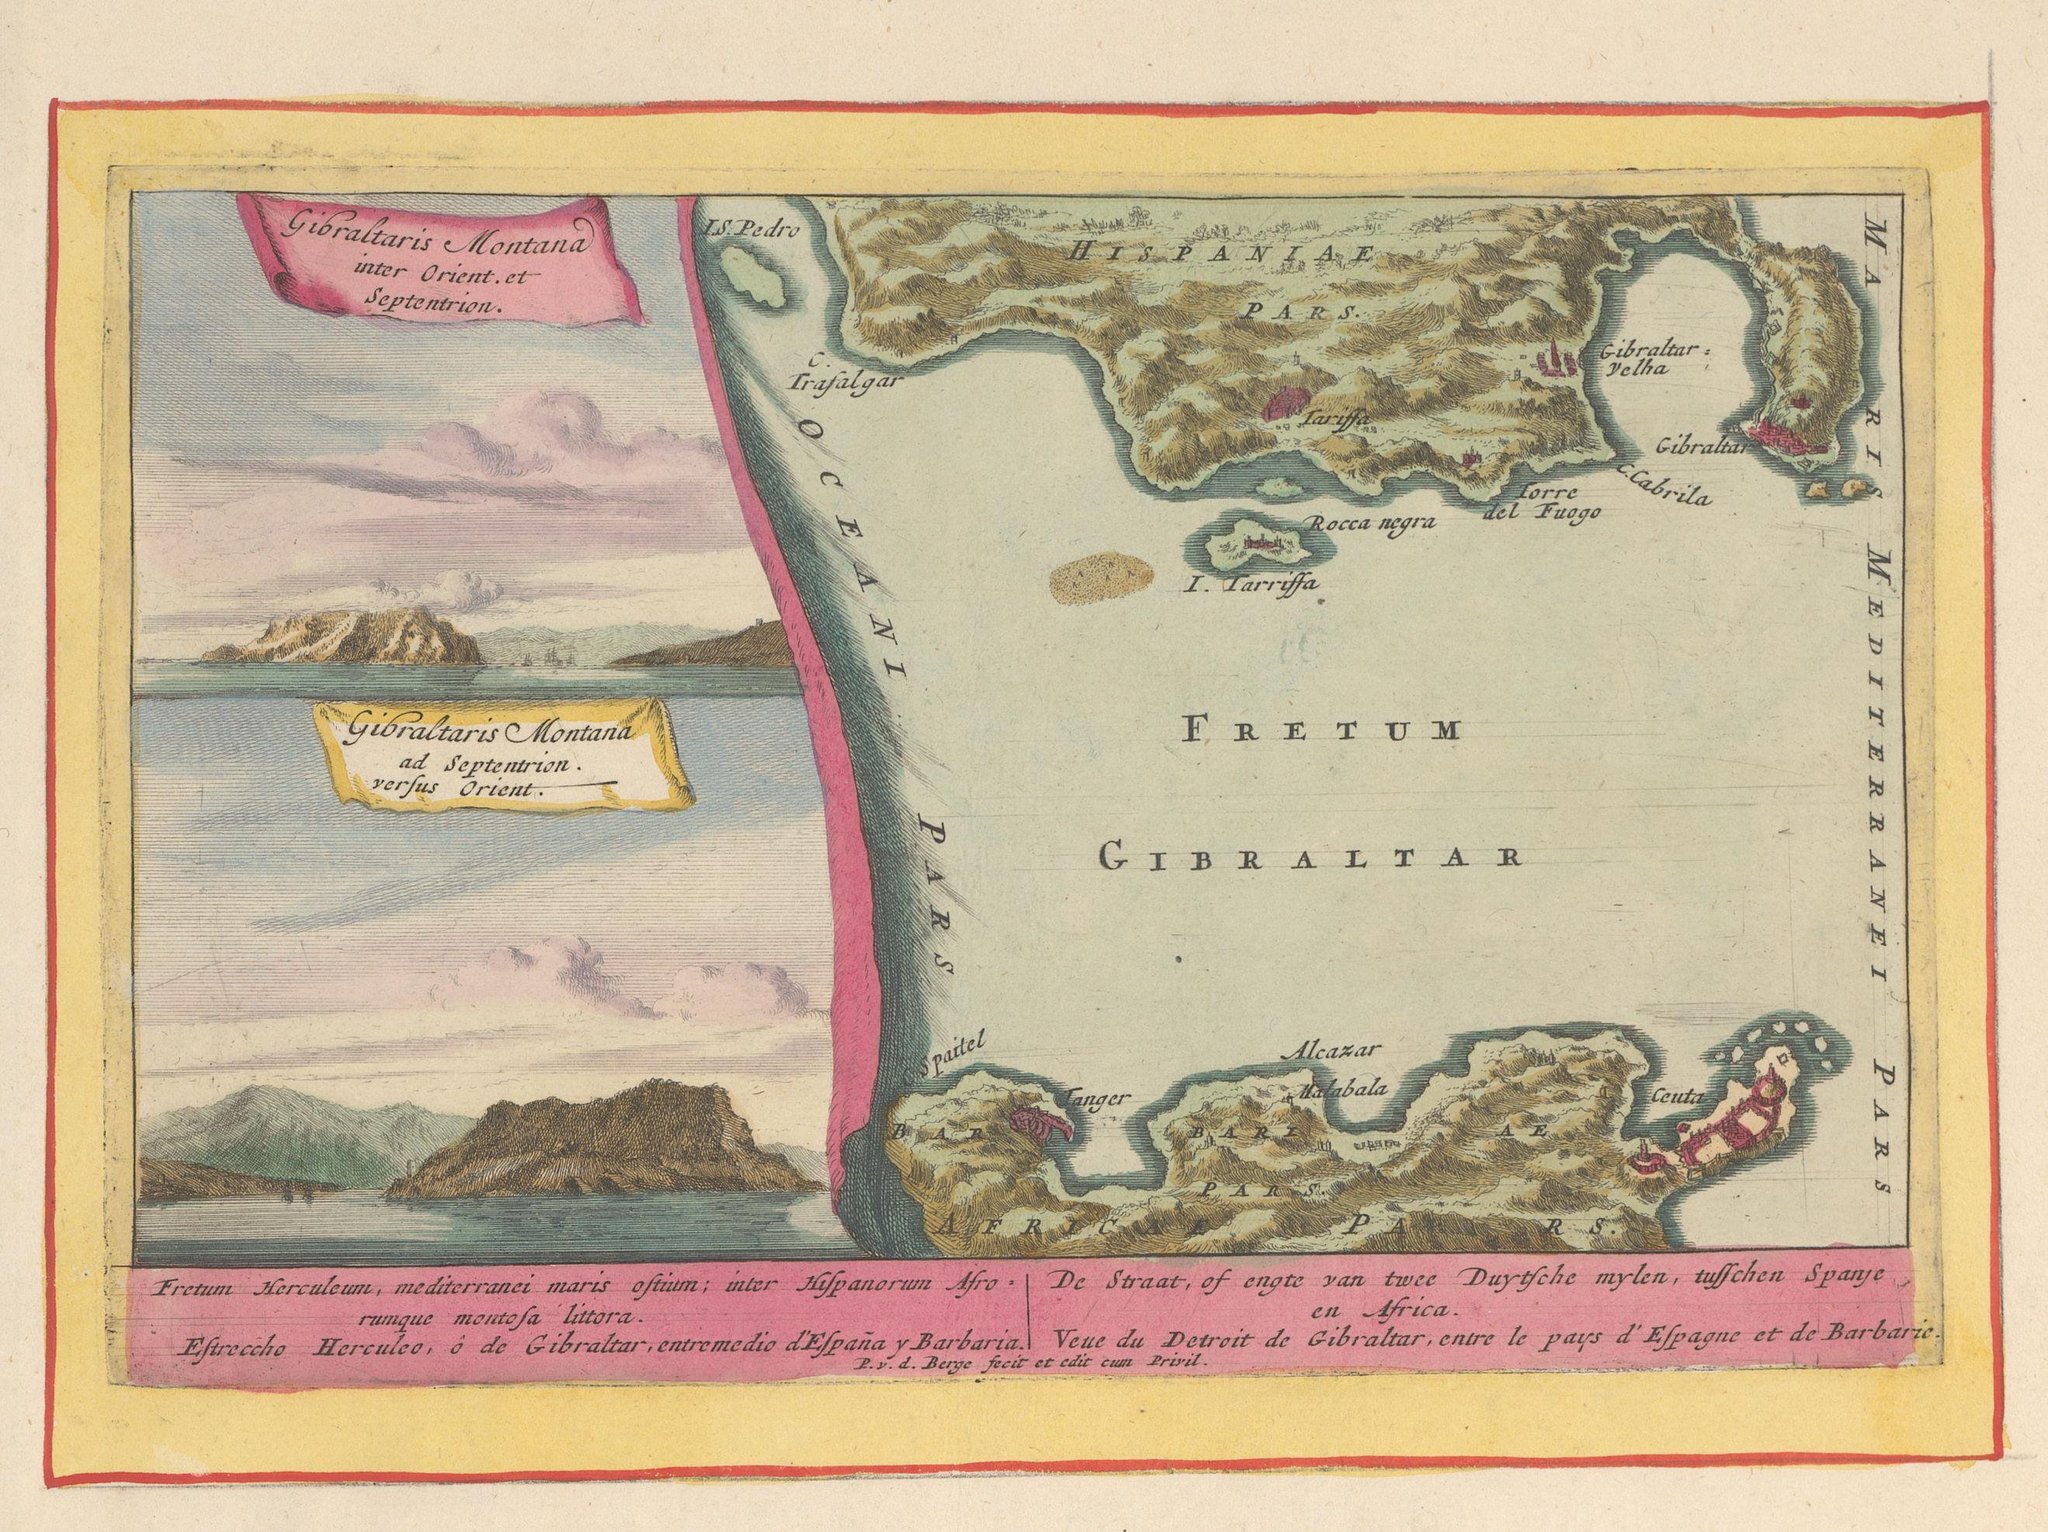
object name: map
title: Gezicht op de rots van Gibraltar en een kaart van de straat van Gibraltar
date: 1694-1737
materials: paper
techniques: etching, hand coloring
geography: amsterdam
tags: maps, atlases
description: Links een gezicht op de rots van Gibraltar en rechts een kaart van de straat van Gibraltar. Onder de voorstelling een titel in het Latijn, Spaans, Nederlands en Frans. Prent maakt deel uit van een album.